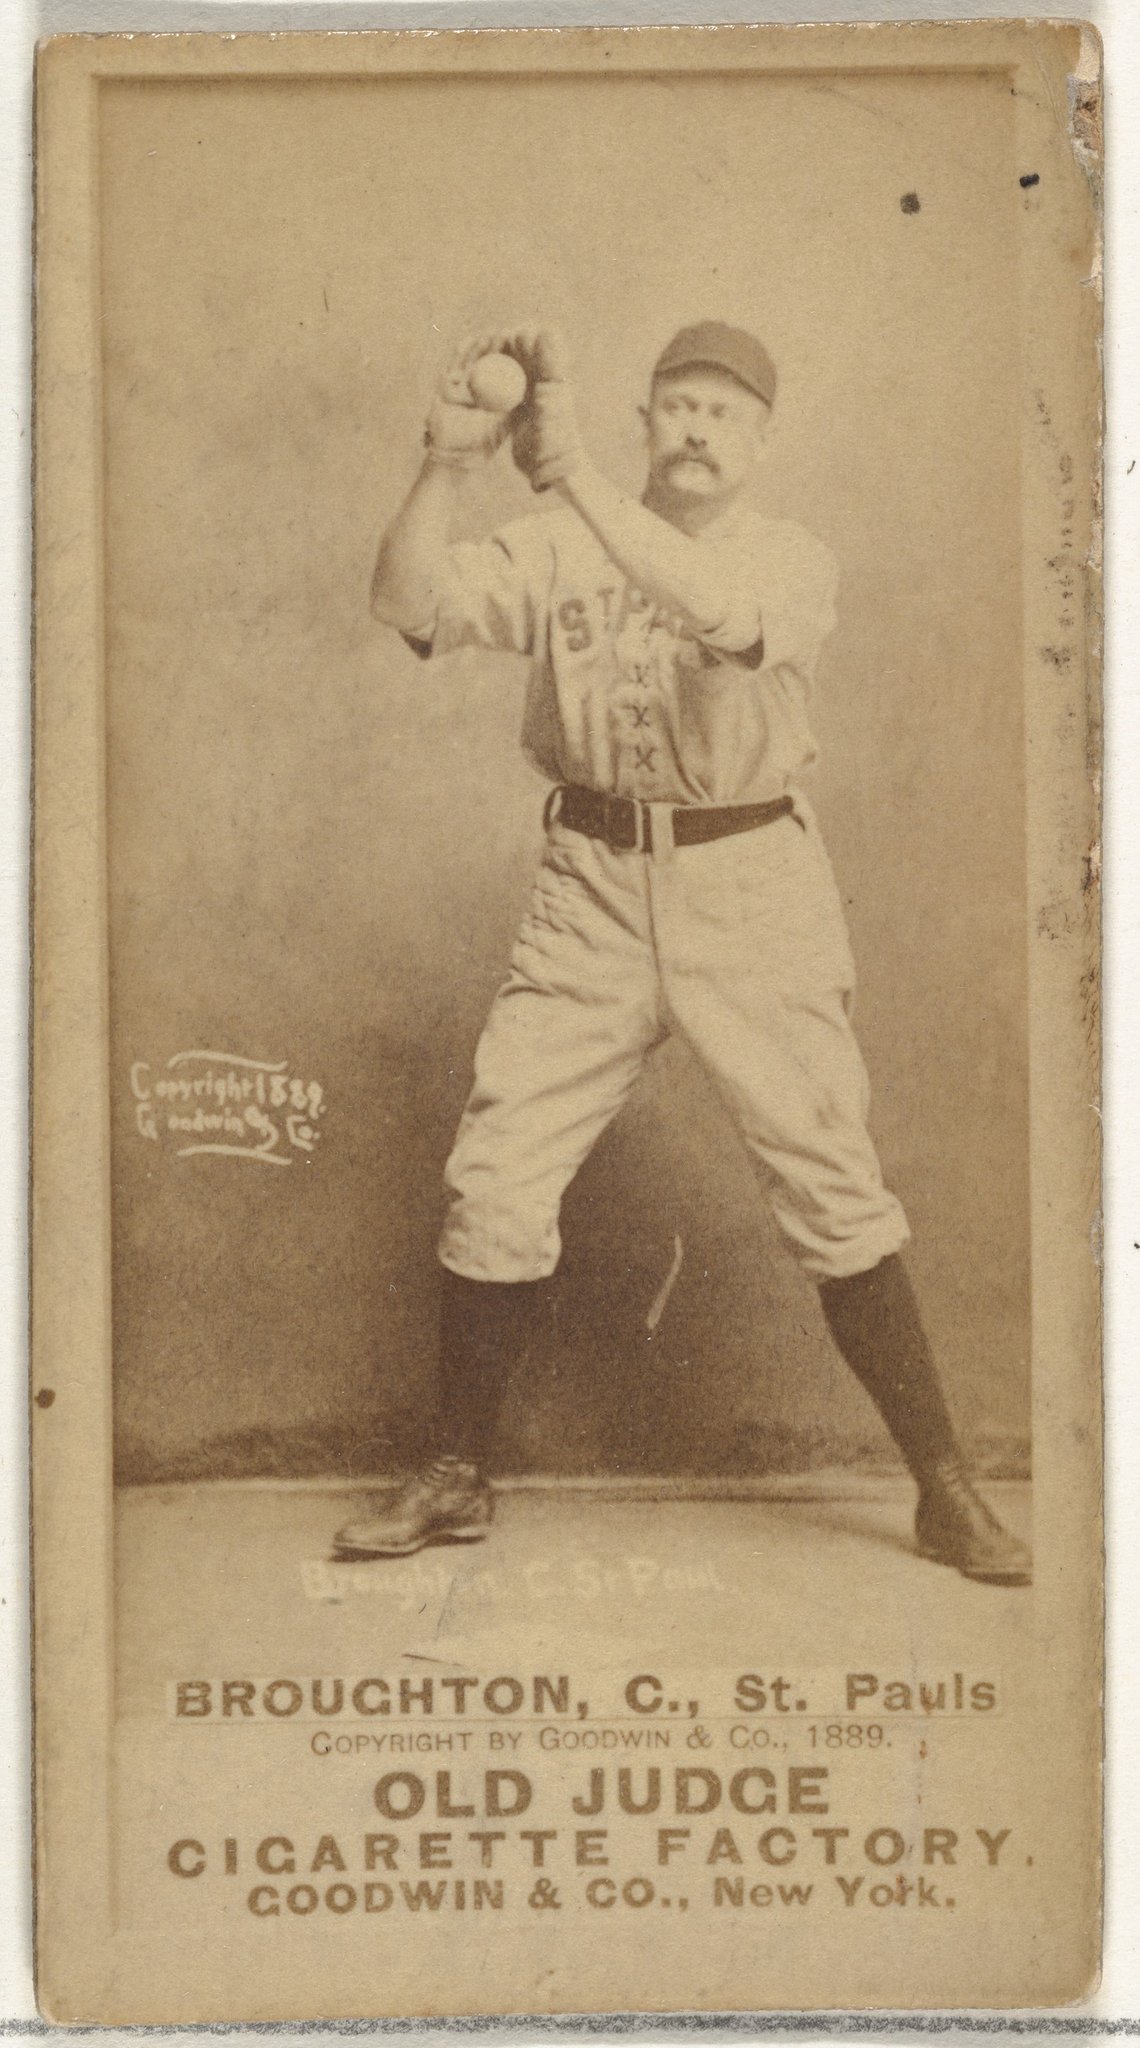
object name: baseball card, photograph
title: Cecil Calvert "Cal" Broughton, Catcher, St. Paul Apostles, from the Old Judge series (N172) for Old Judge Cigarettes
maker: goodwin & company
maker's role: publisher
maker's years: 1850-1950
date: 1889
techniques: albumen silver print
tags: men,portraits,baseball,athletes